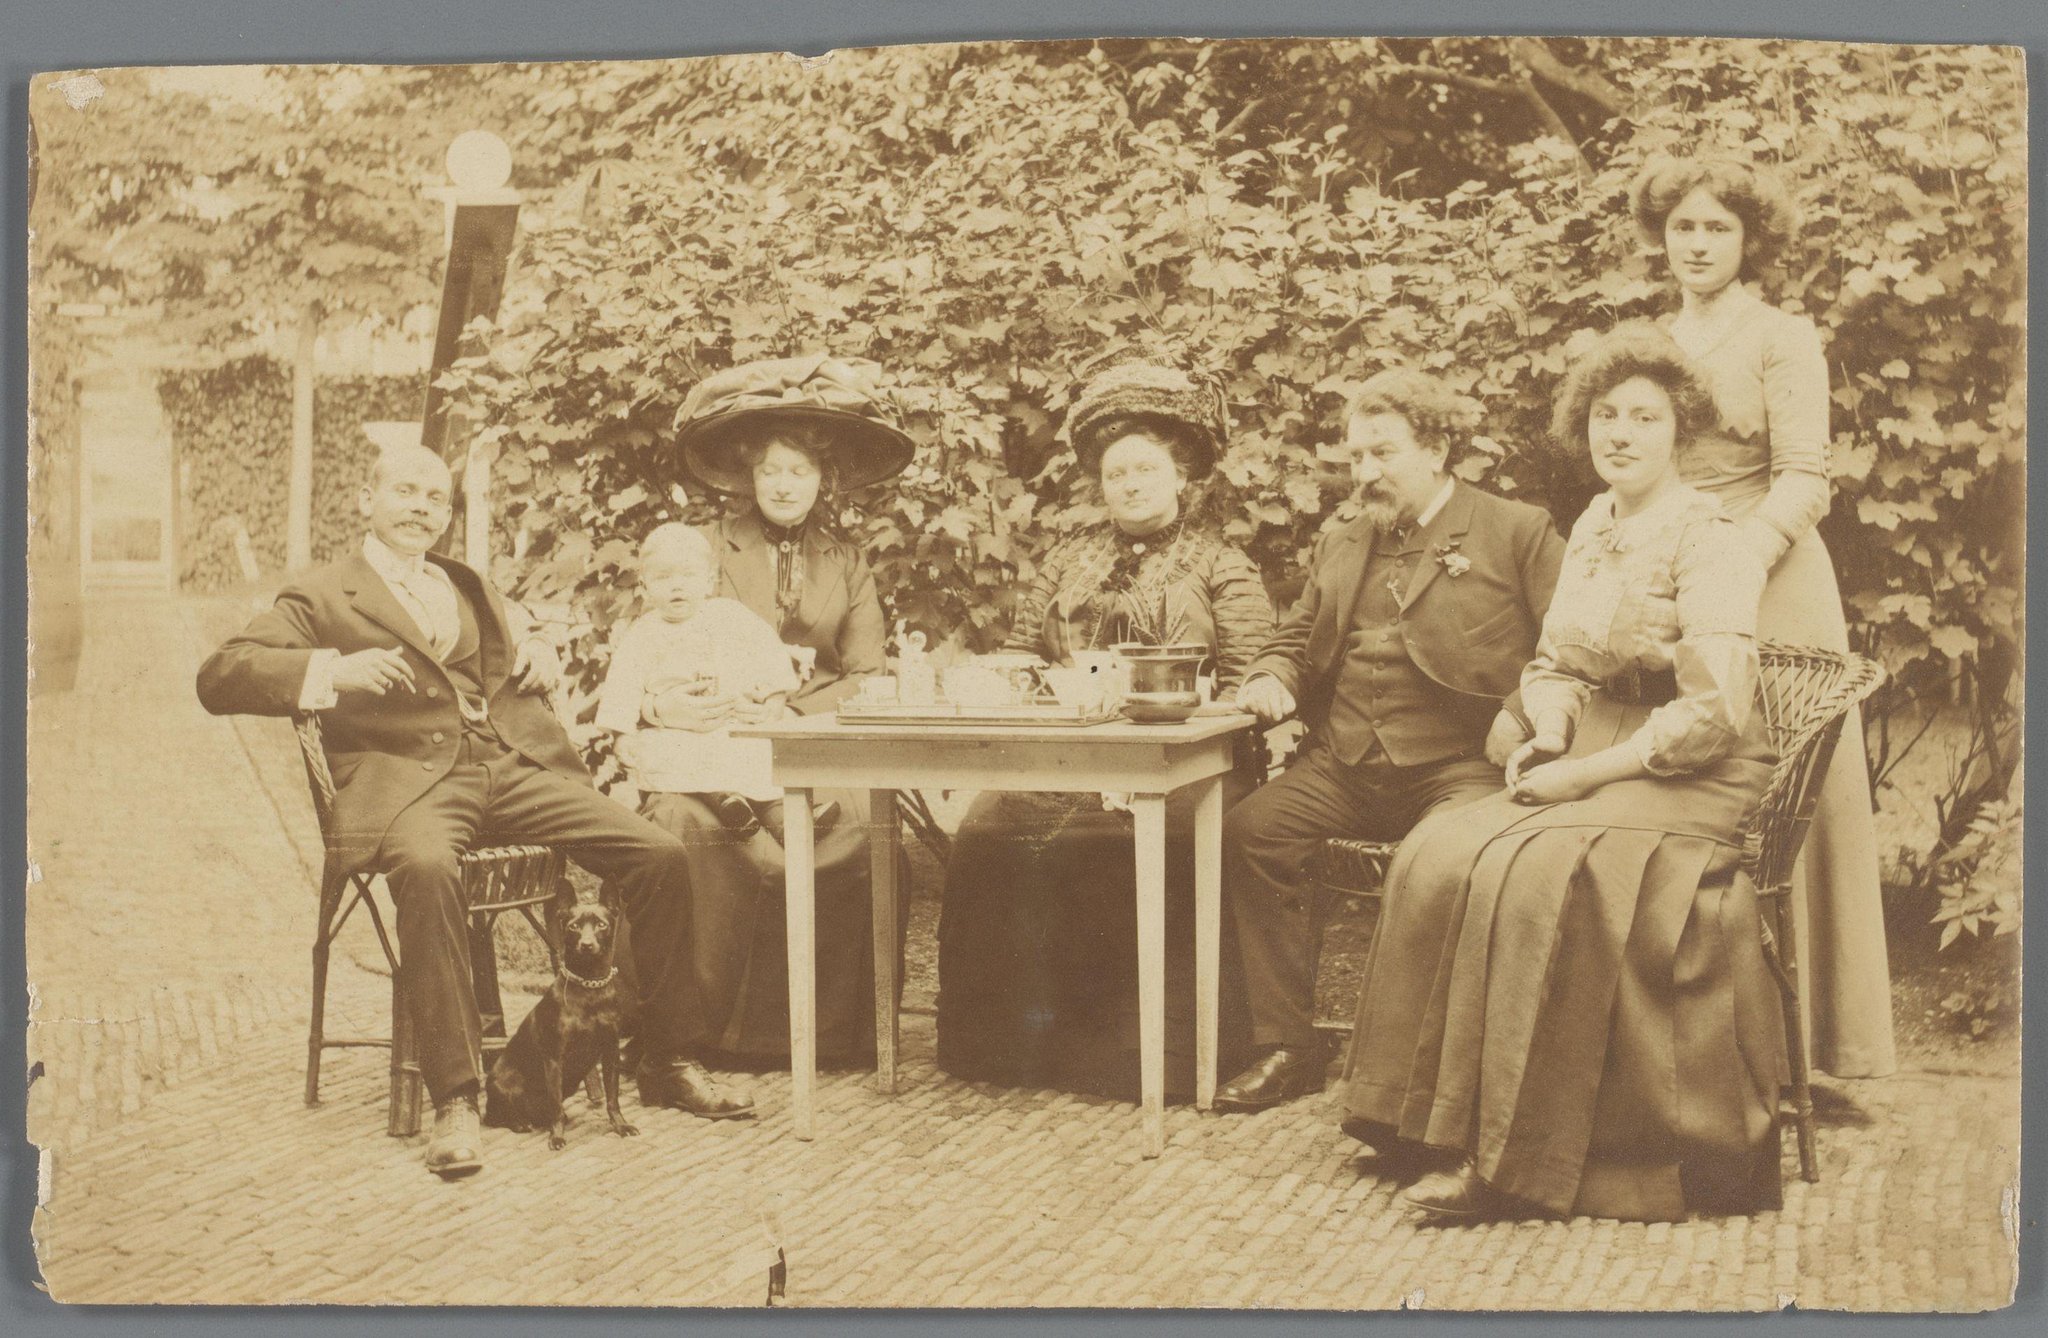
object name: photograph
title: Portret van een groep onbekende mannen en vrouwen, een baby en een hond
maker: Anonymous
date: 1900-1920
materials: paper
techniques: gelatin silver print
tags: adult man (+ two persons), historical persons, adult woman (+ three persons), infant, baby, dog